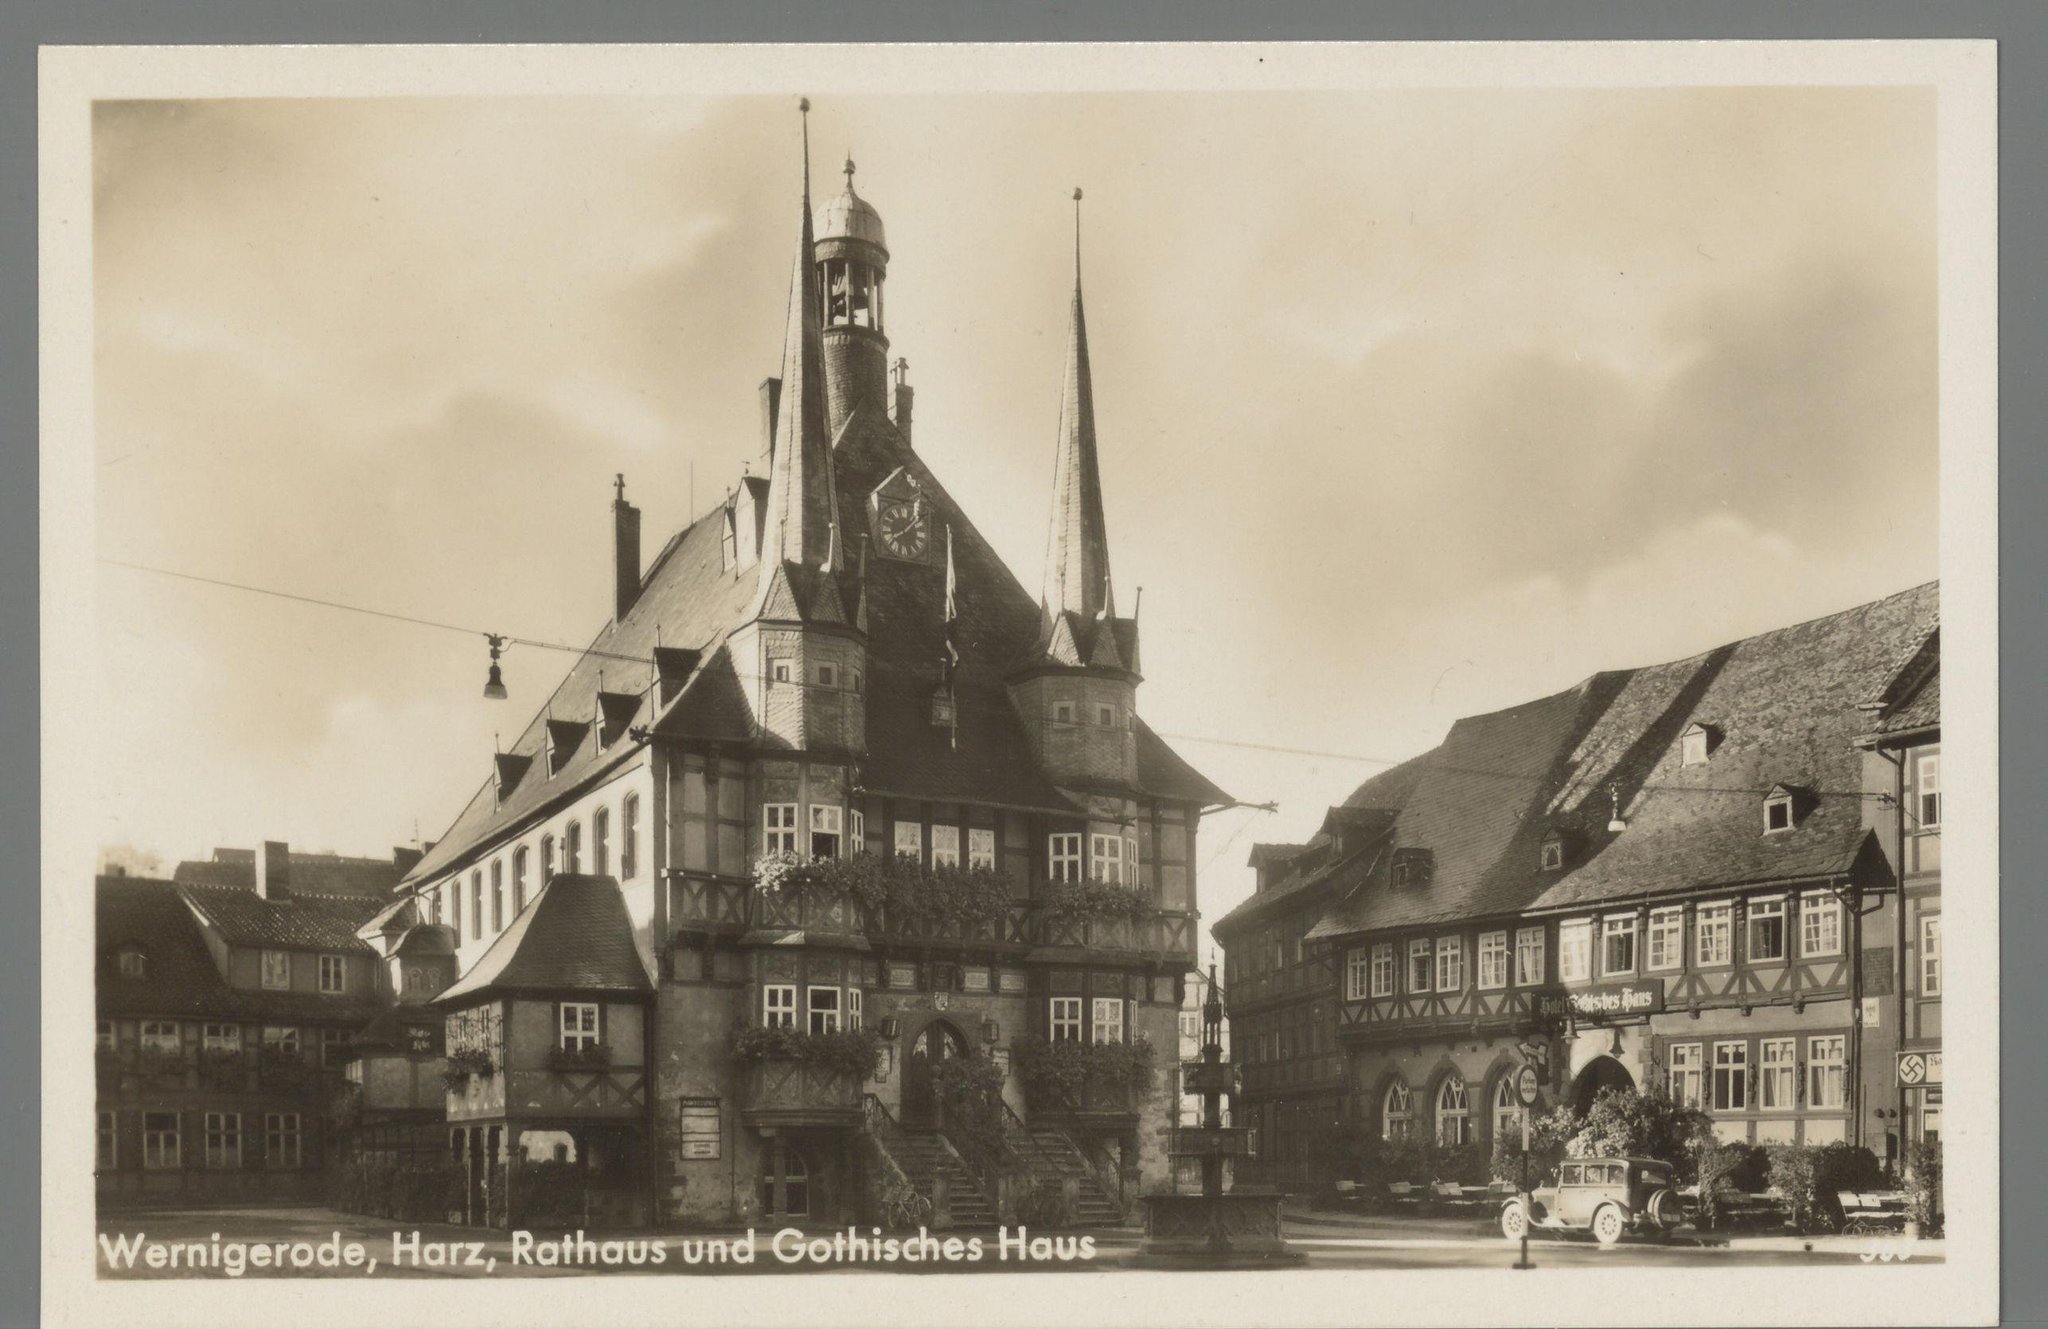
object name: ansichtkaart, prentbriefkaart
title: Wernigerode, Harz, Rathaus und Gothisches Haus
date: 1905-1940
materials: photographic support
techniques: gelatin silver print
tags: urban housing, specific forms of the cross: swastika, townhall